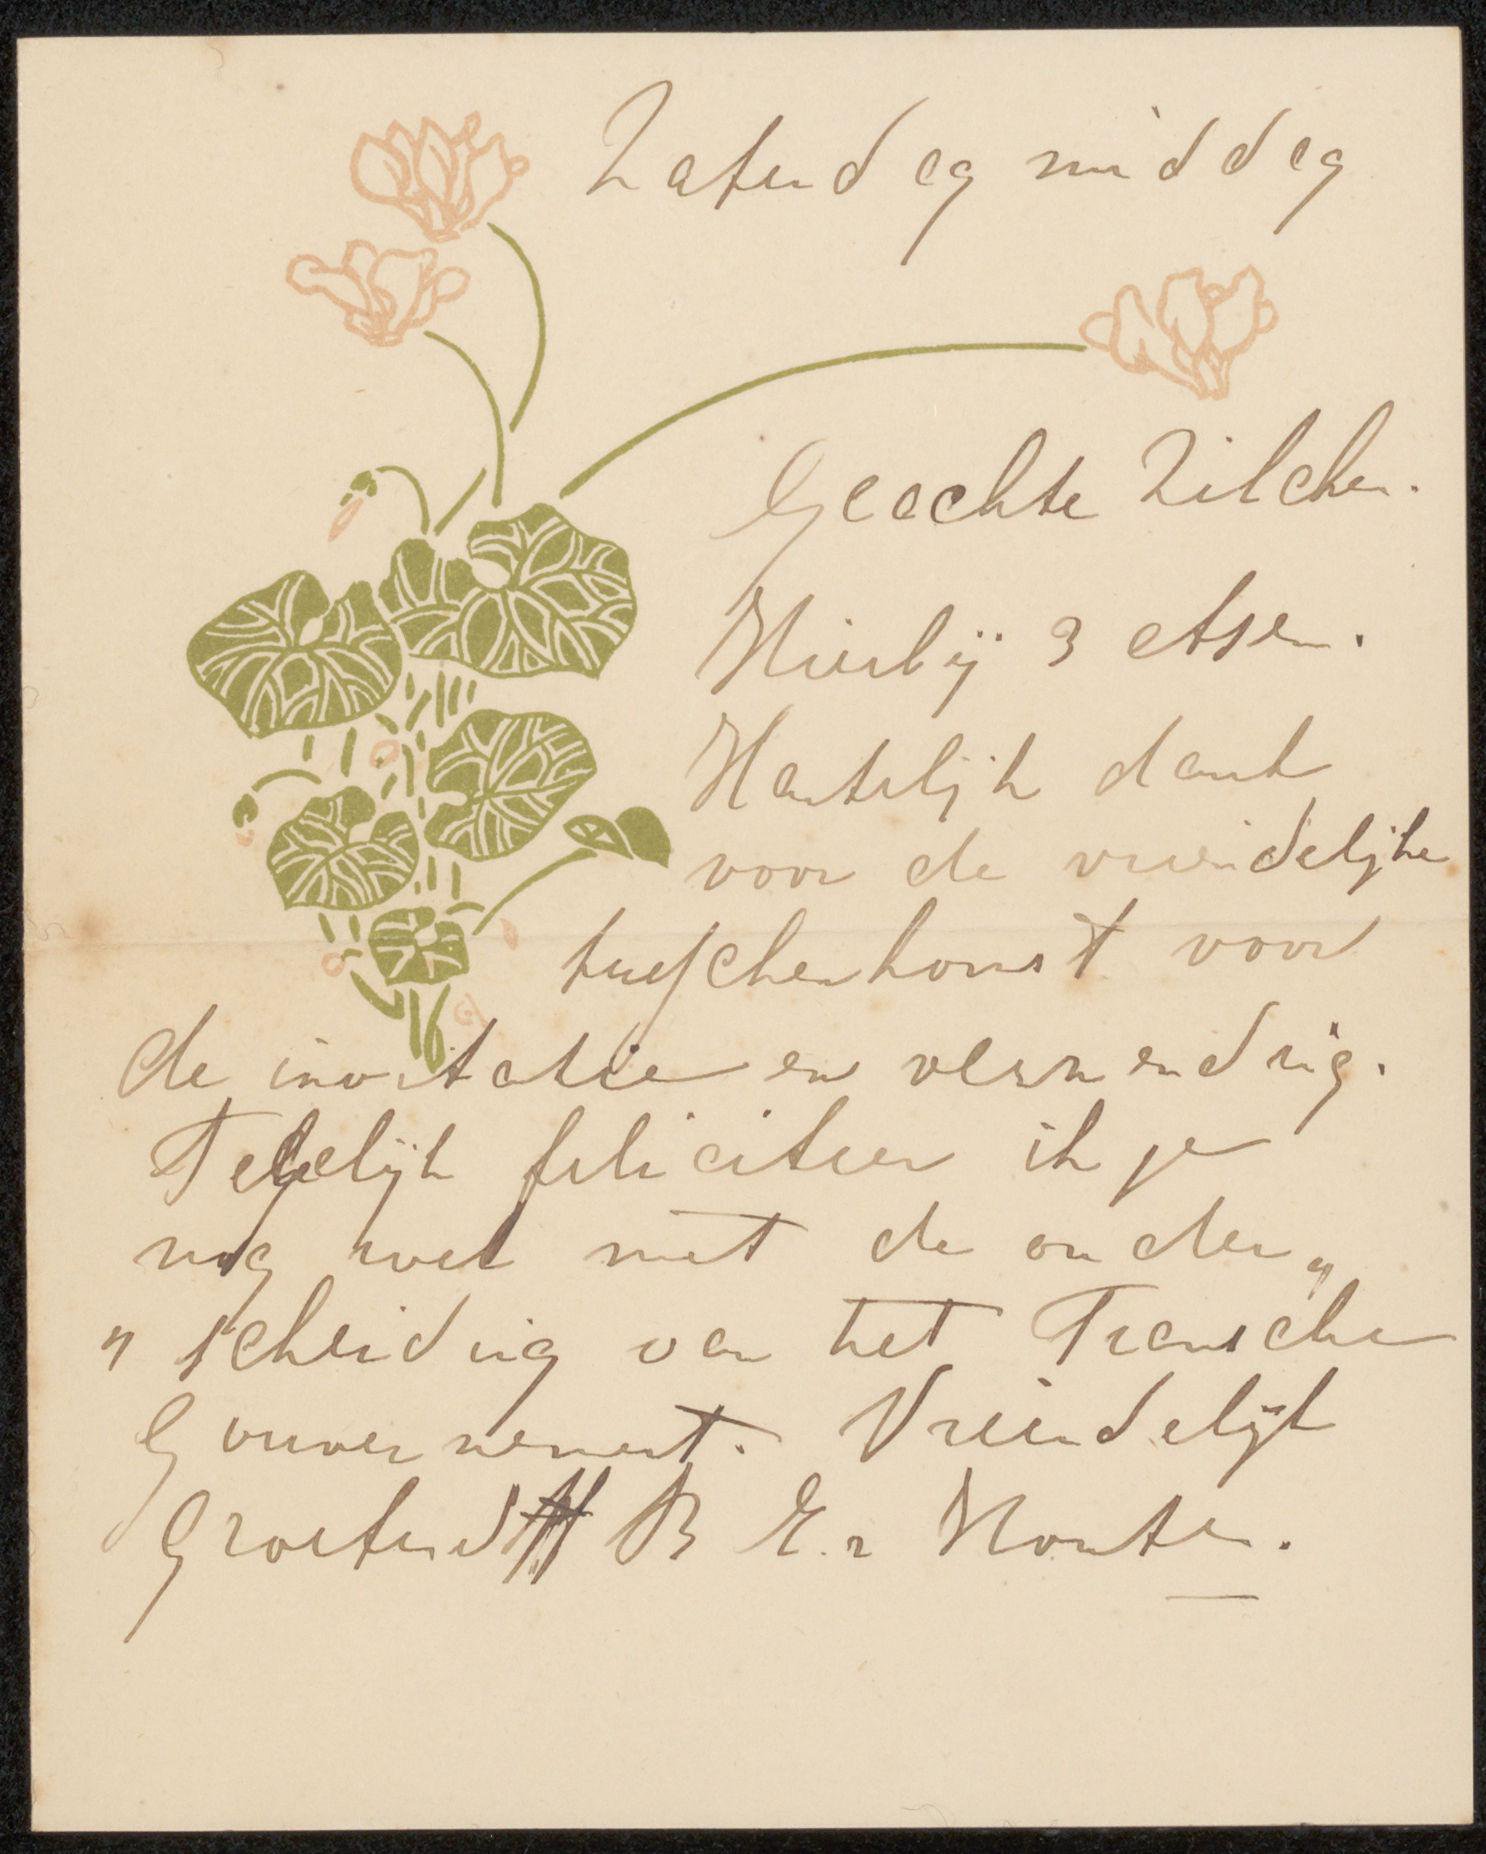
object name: letter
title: Brief aan Philip Zilcken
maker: barbara elisabeth van houten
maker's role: draughtsman, print maker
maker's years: 1862-1950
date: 1872-1930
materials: ink, paper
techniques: pen, printing, writing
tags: painter, philip zilcken, the graphic arts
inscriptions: collector's mark: ‘RPK’